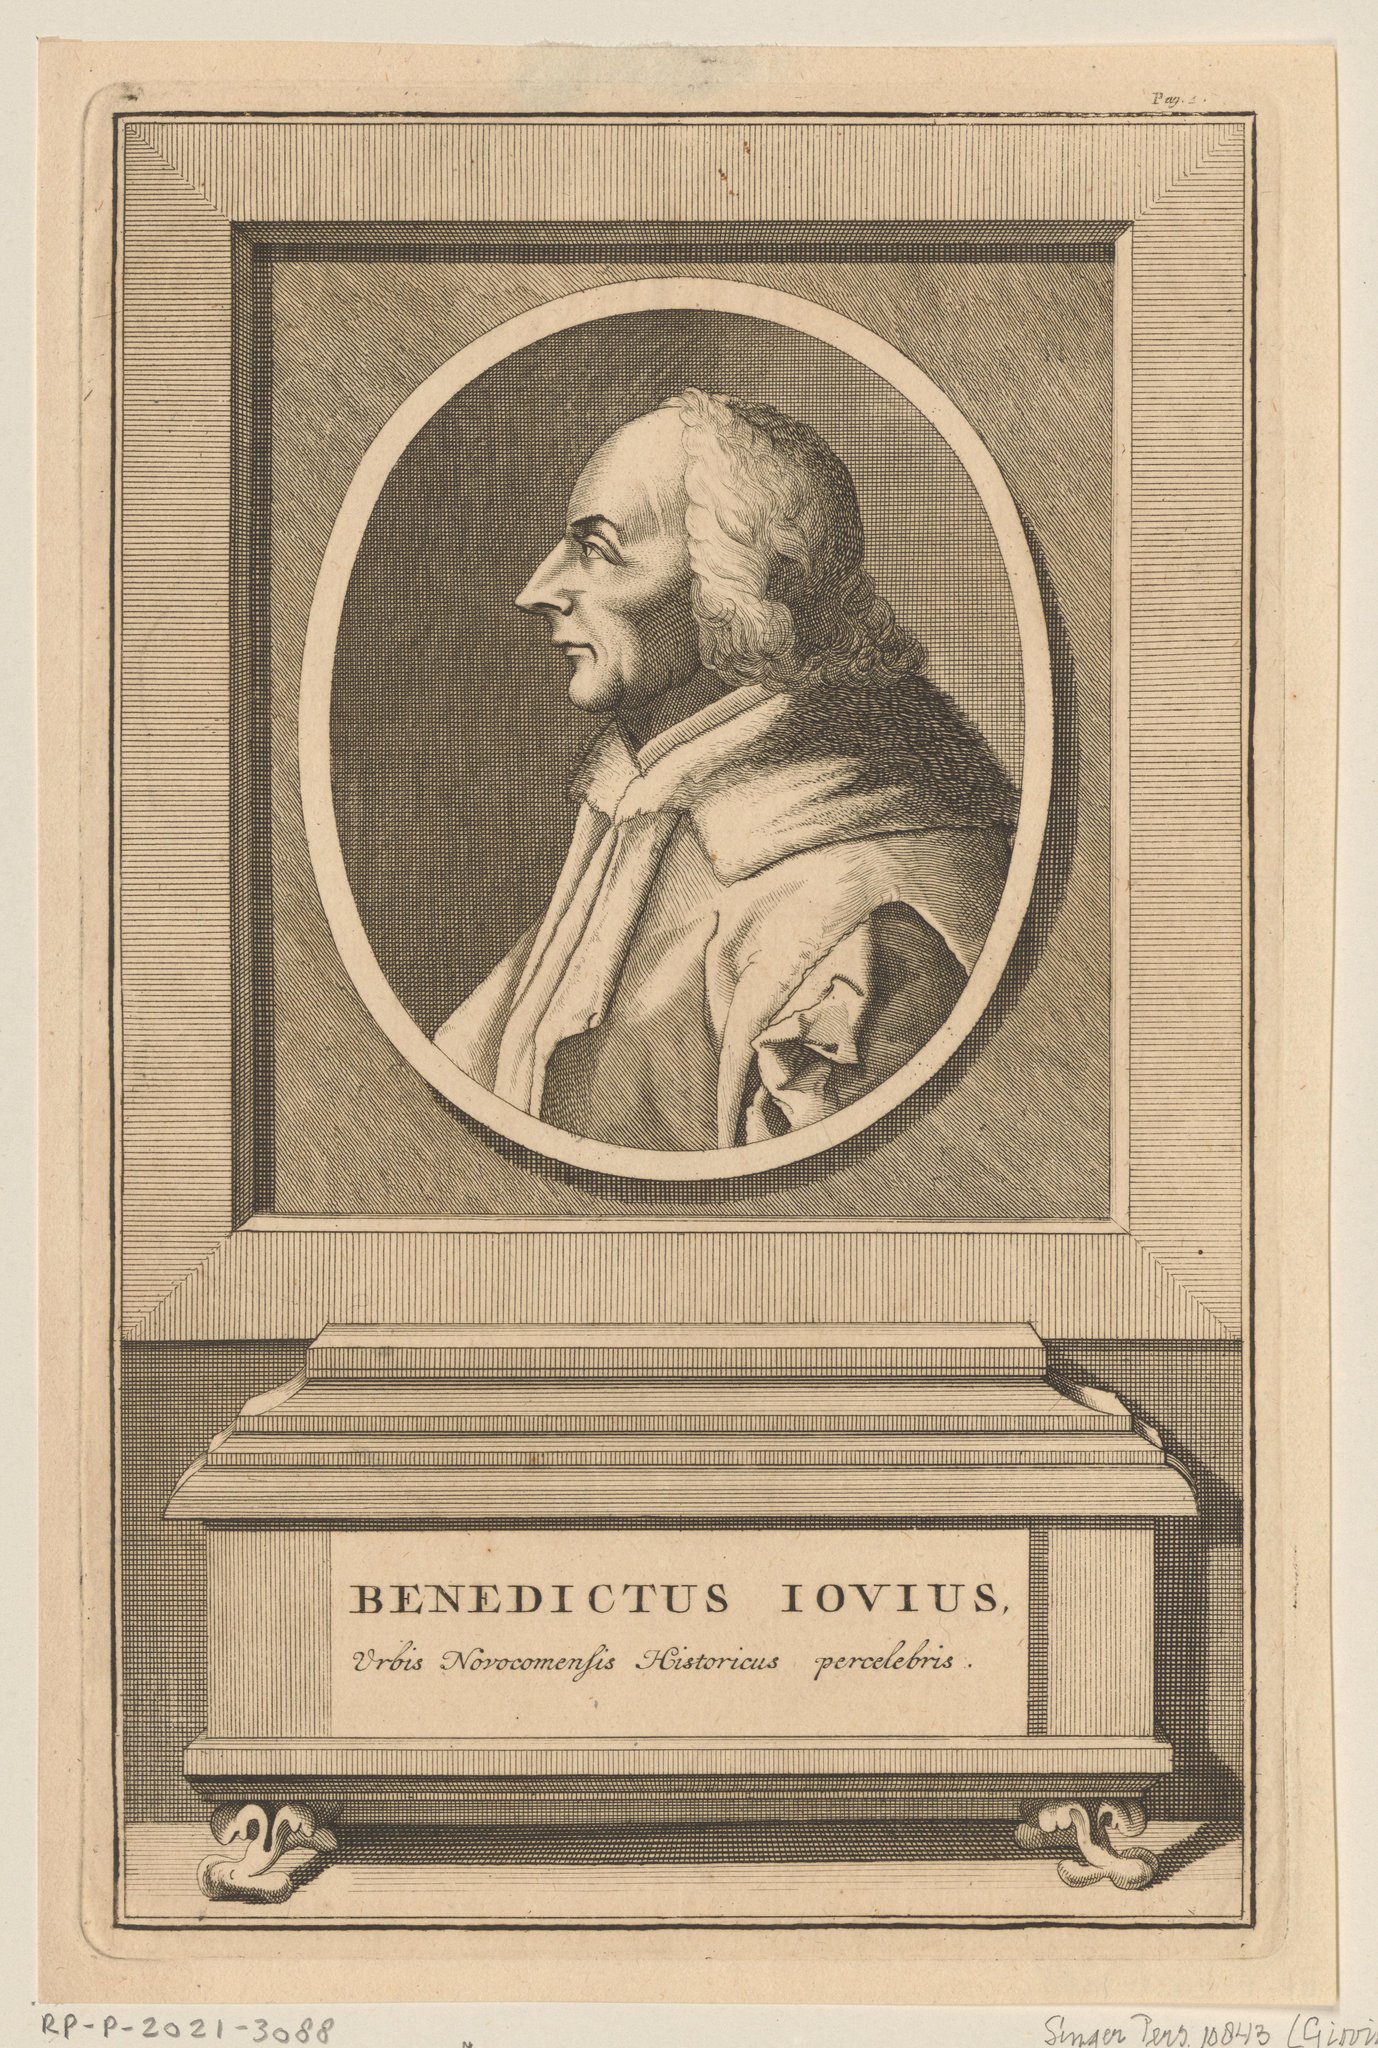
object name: print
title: Portret van Benedetto Giovio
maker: Anonymous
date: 1722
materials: paper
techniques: engraving, etching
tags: historical persons, portrait of a writer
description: Prent mogelijk uit: Graevius, Johann Georg. Thesaurus antiquitatum et historiarum Italiae, Neapolis, Siciliae (...) Leiden: Pieter van der Aa, 1722, dl. 4.